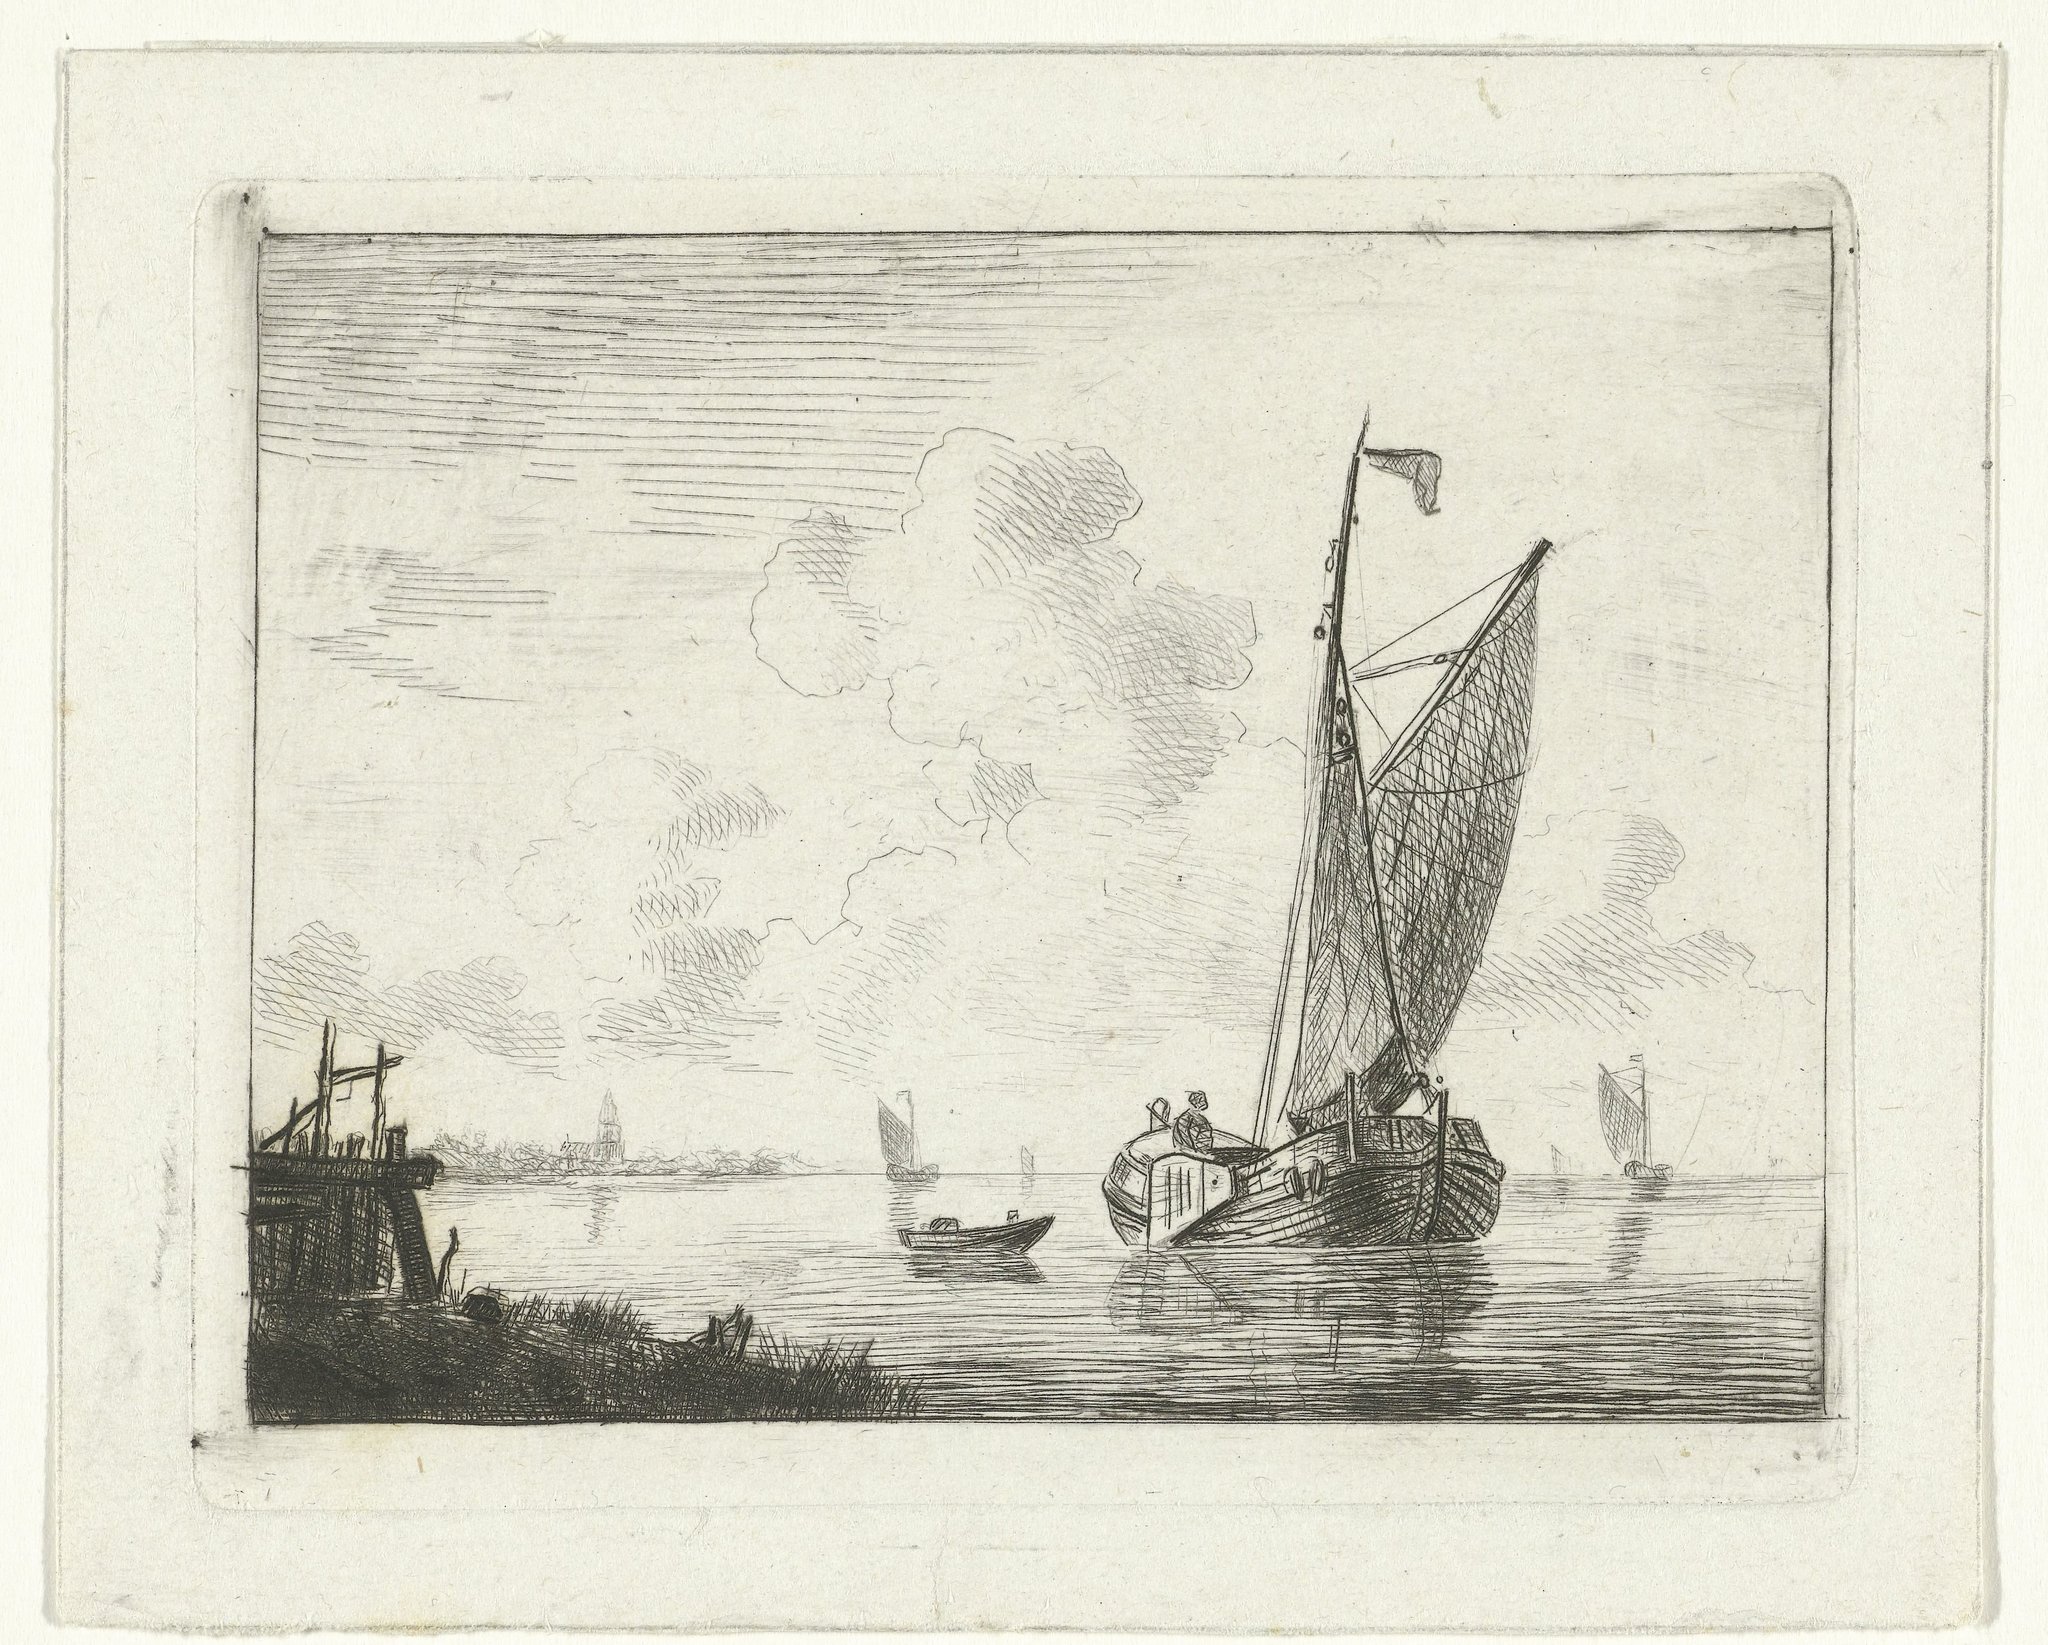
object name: print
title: Zeilboot op binnenwater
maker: willem gruyter jr.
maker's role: draughtsman, print maker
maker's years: 1817-1880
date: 1832-1880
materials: paper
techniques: engraving, etching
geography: amsterdam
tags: sailing-ship, sailing-boat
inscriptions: collector's mark: Lugt 2165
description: Zeilboot op binnenwater met daarachter een roeiboot, links een steiger en op de achtergrond een dorp.